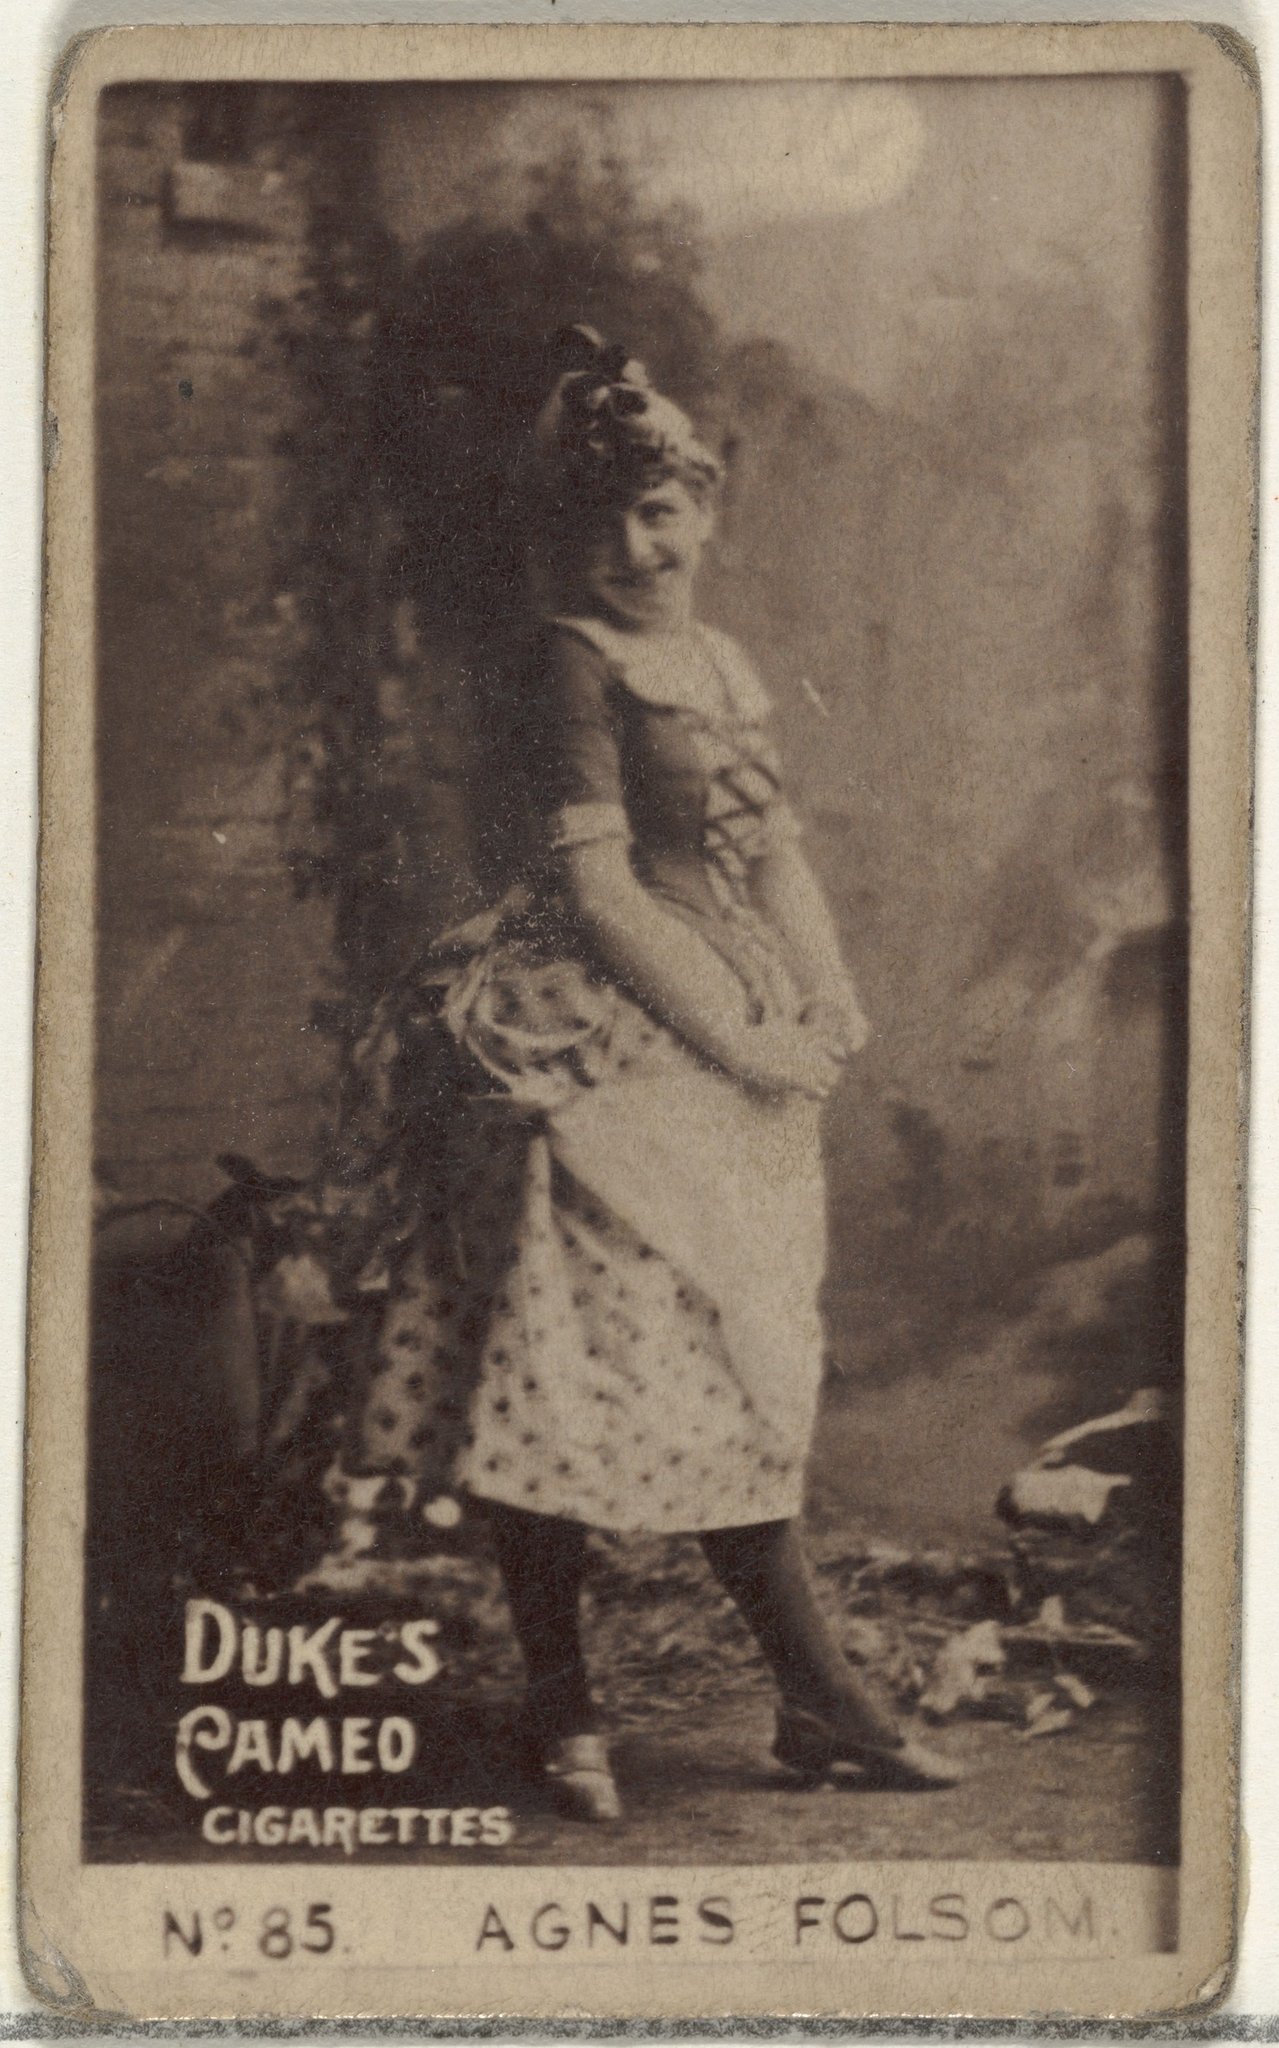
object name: photograph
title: Card Number 85, Agnes Folsom, from the Actors and Actresses series (N145-4) issued by Duke Sons & Co. to promote Cameo Cigarettes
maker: w. duke, sons & co.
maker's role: publisher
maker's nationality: american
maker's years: 1870-1920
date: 1880-1889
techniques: albumen silver print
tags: portraits,women,actresses